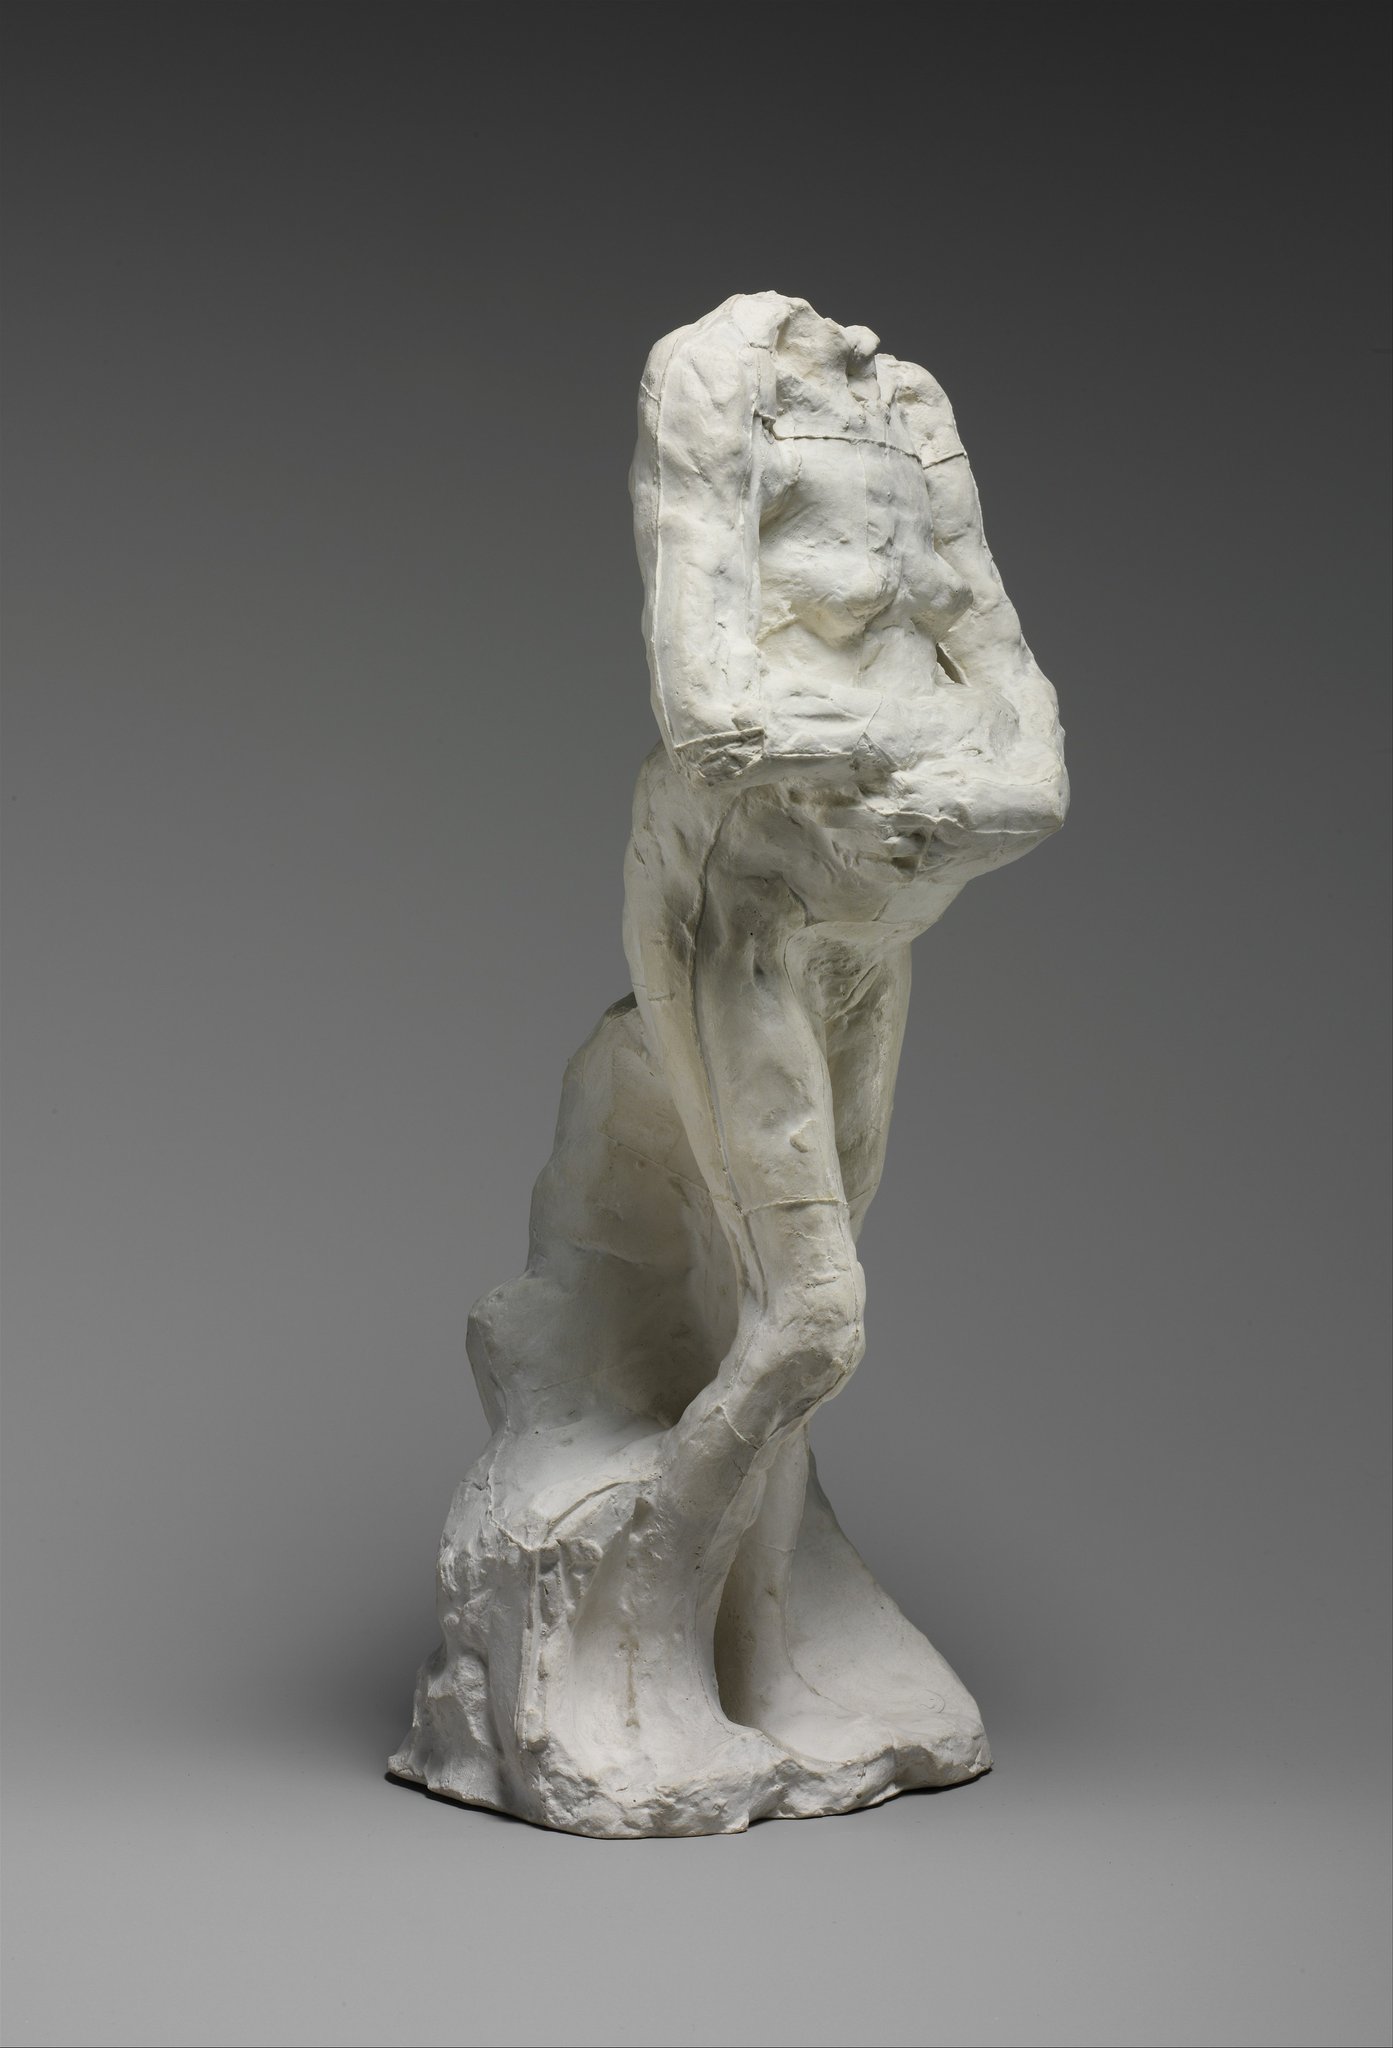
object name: cast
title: Old Woman Standing with Folded Arms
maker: auguste rodin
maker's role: artist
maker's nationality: french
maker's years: 1840-1917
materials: plaster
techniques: casting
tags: women